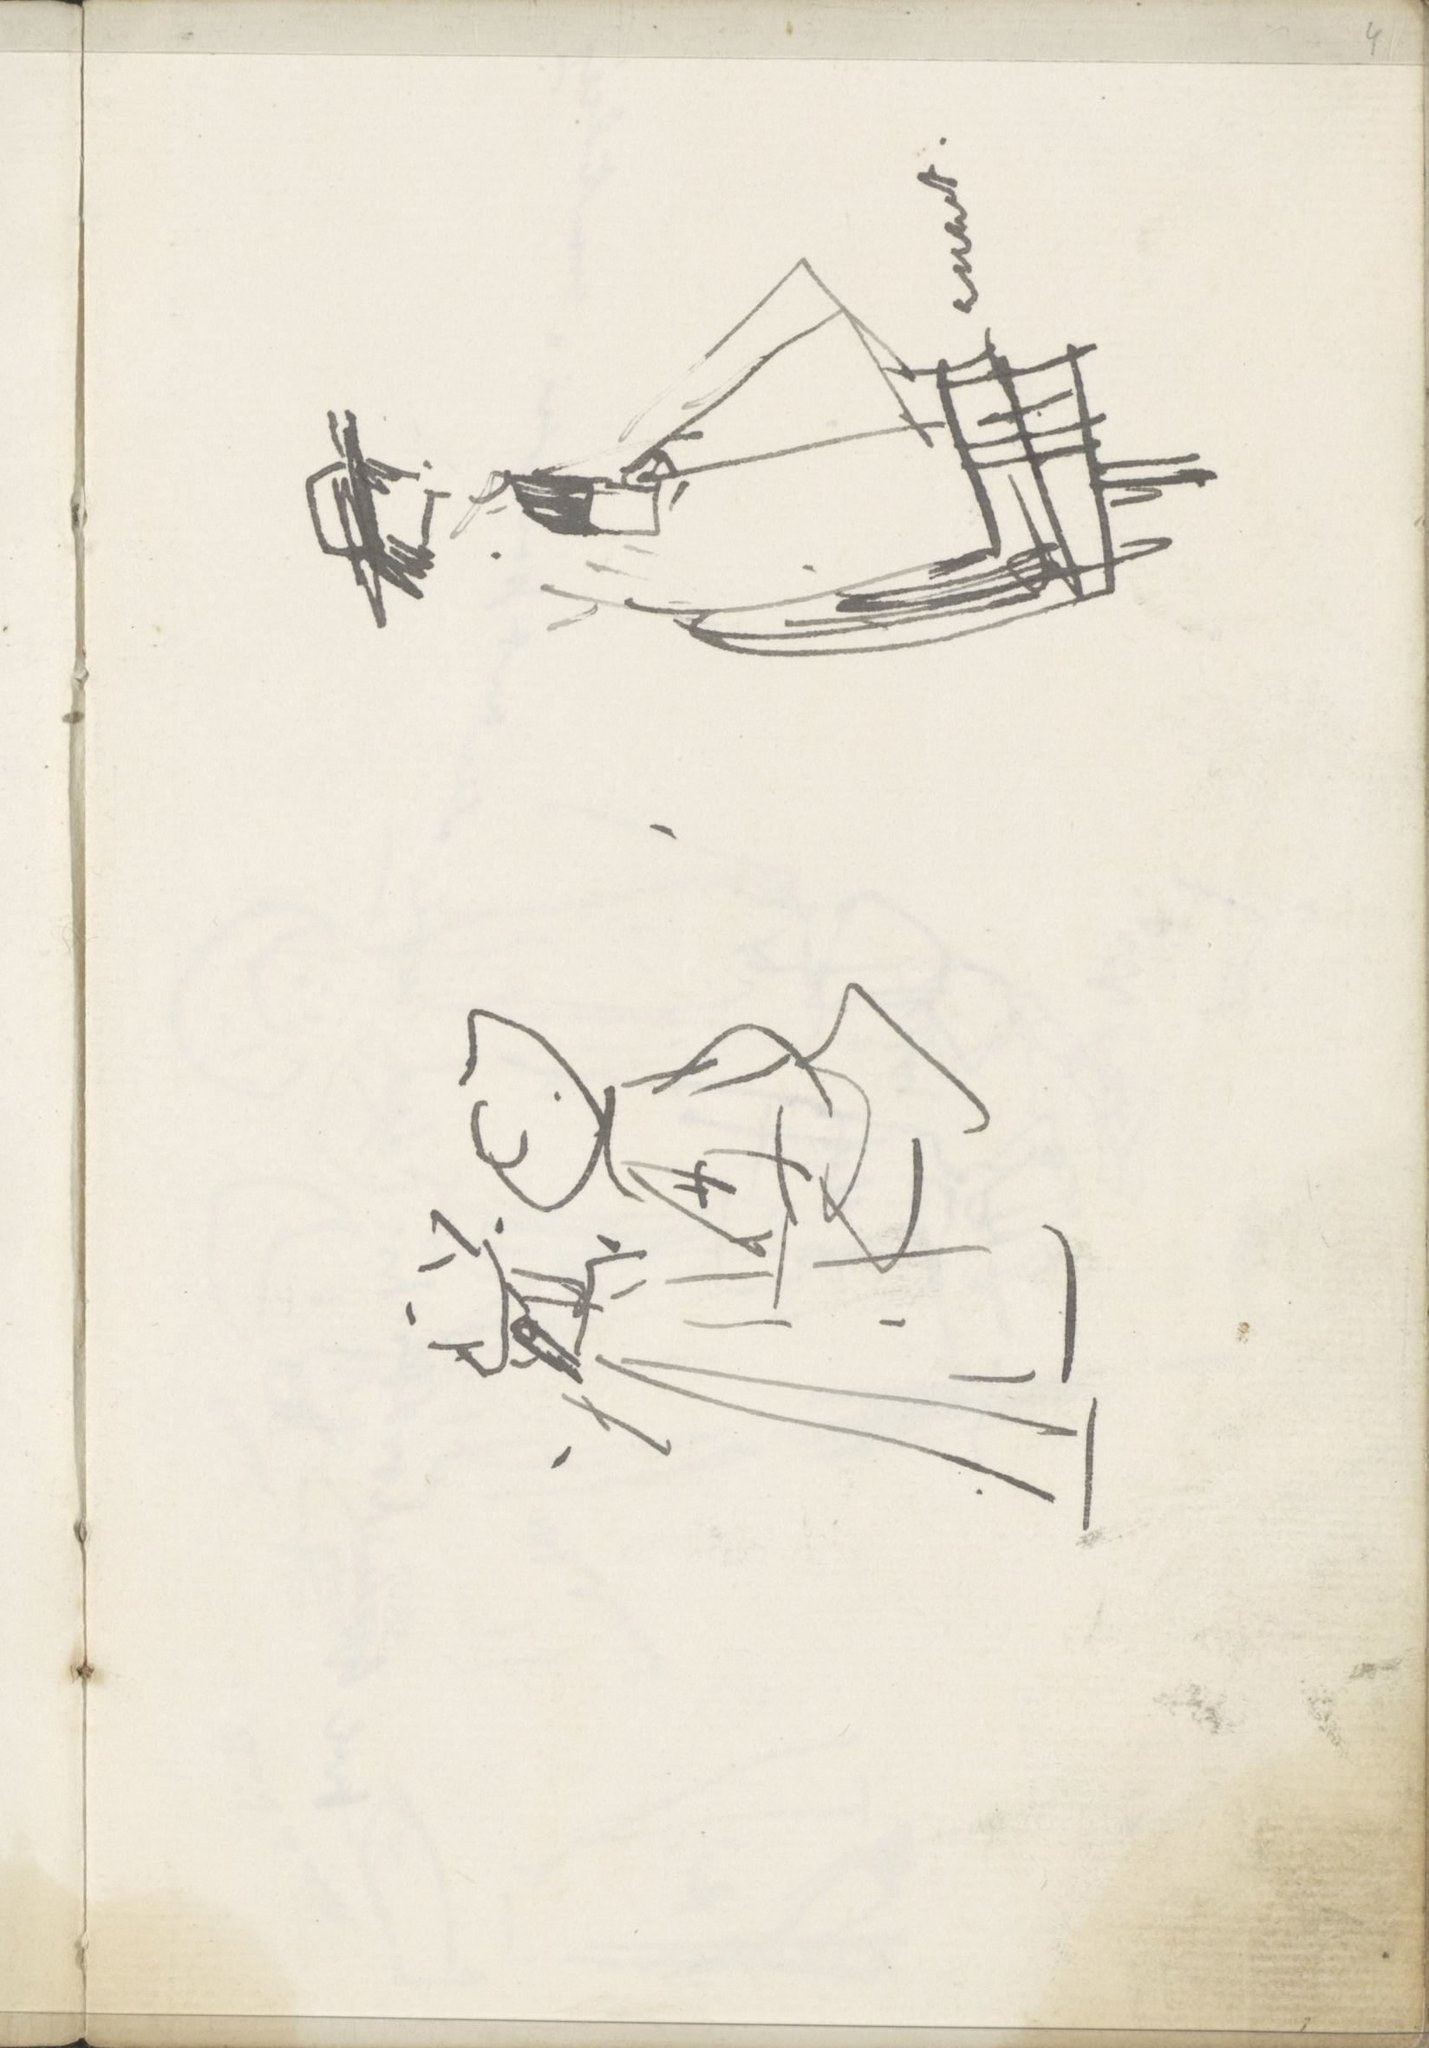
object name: sketchbook leaf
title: Vrouwen met hoeden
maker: george hendrik breitner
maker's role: draughtsman, painter, print maker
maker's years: 1857-1923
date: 1895-1898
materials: ink, paper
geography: amsterdam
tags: adolescent, young woman, maiden (+ positions (of the human figure)), adult woman (+ positions (of the human figure)), head-gear: hat (+ women's clothes)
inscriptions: : ‘zwart’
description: Pagina 4 uit een schetsboek met 21 bladen.